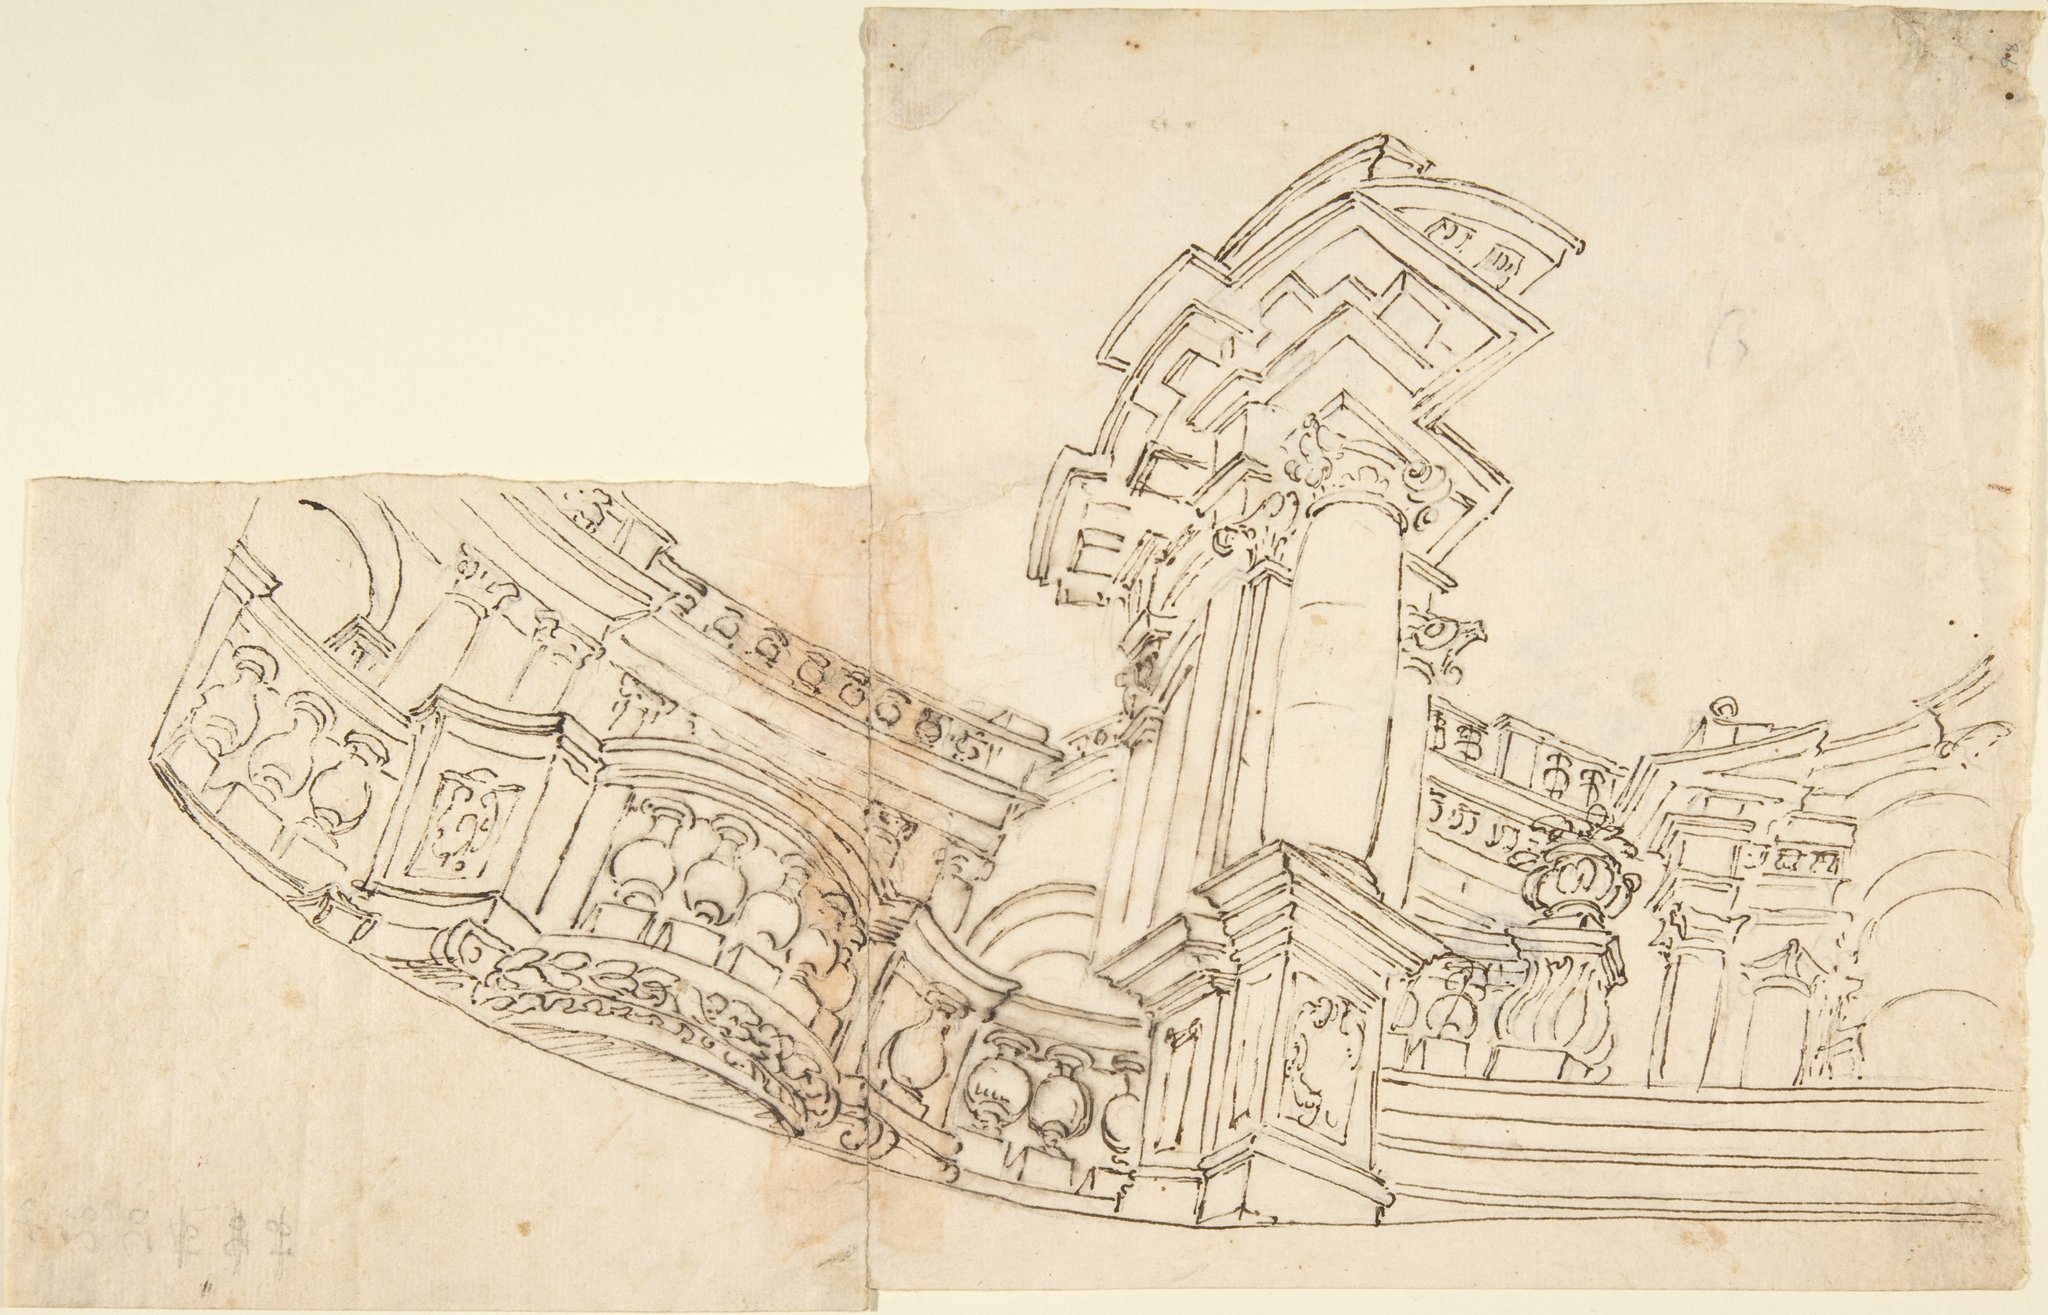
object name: drawing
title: Design for a Balcony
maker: anonymous, italian, piedmontese, 18th century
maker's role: artist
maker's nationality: italian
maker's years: 1700-1800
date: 1700-1780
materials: chalk, ink, drawing material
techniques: pen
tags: balconies